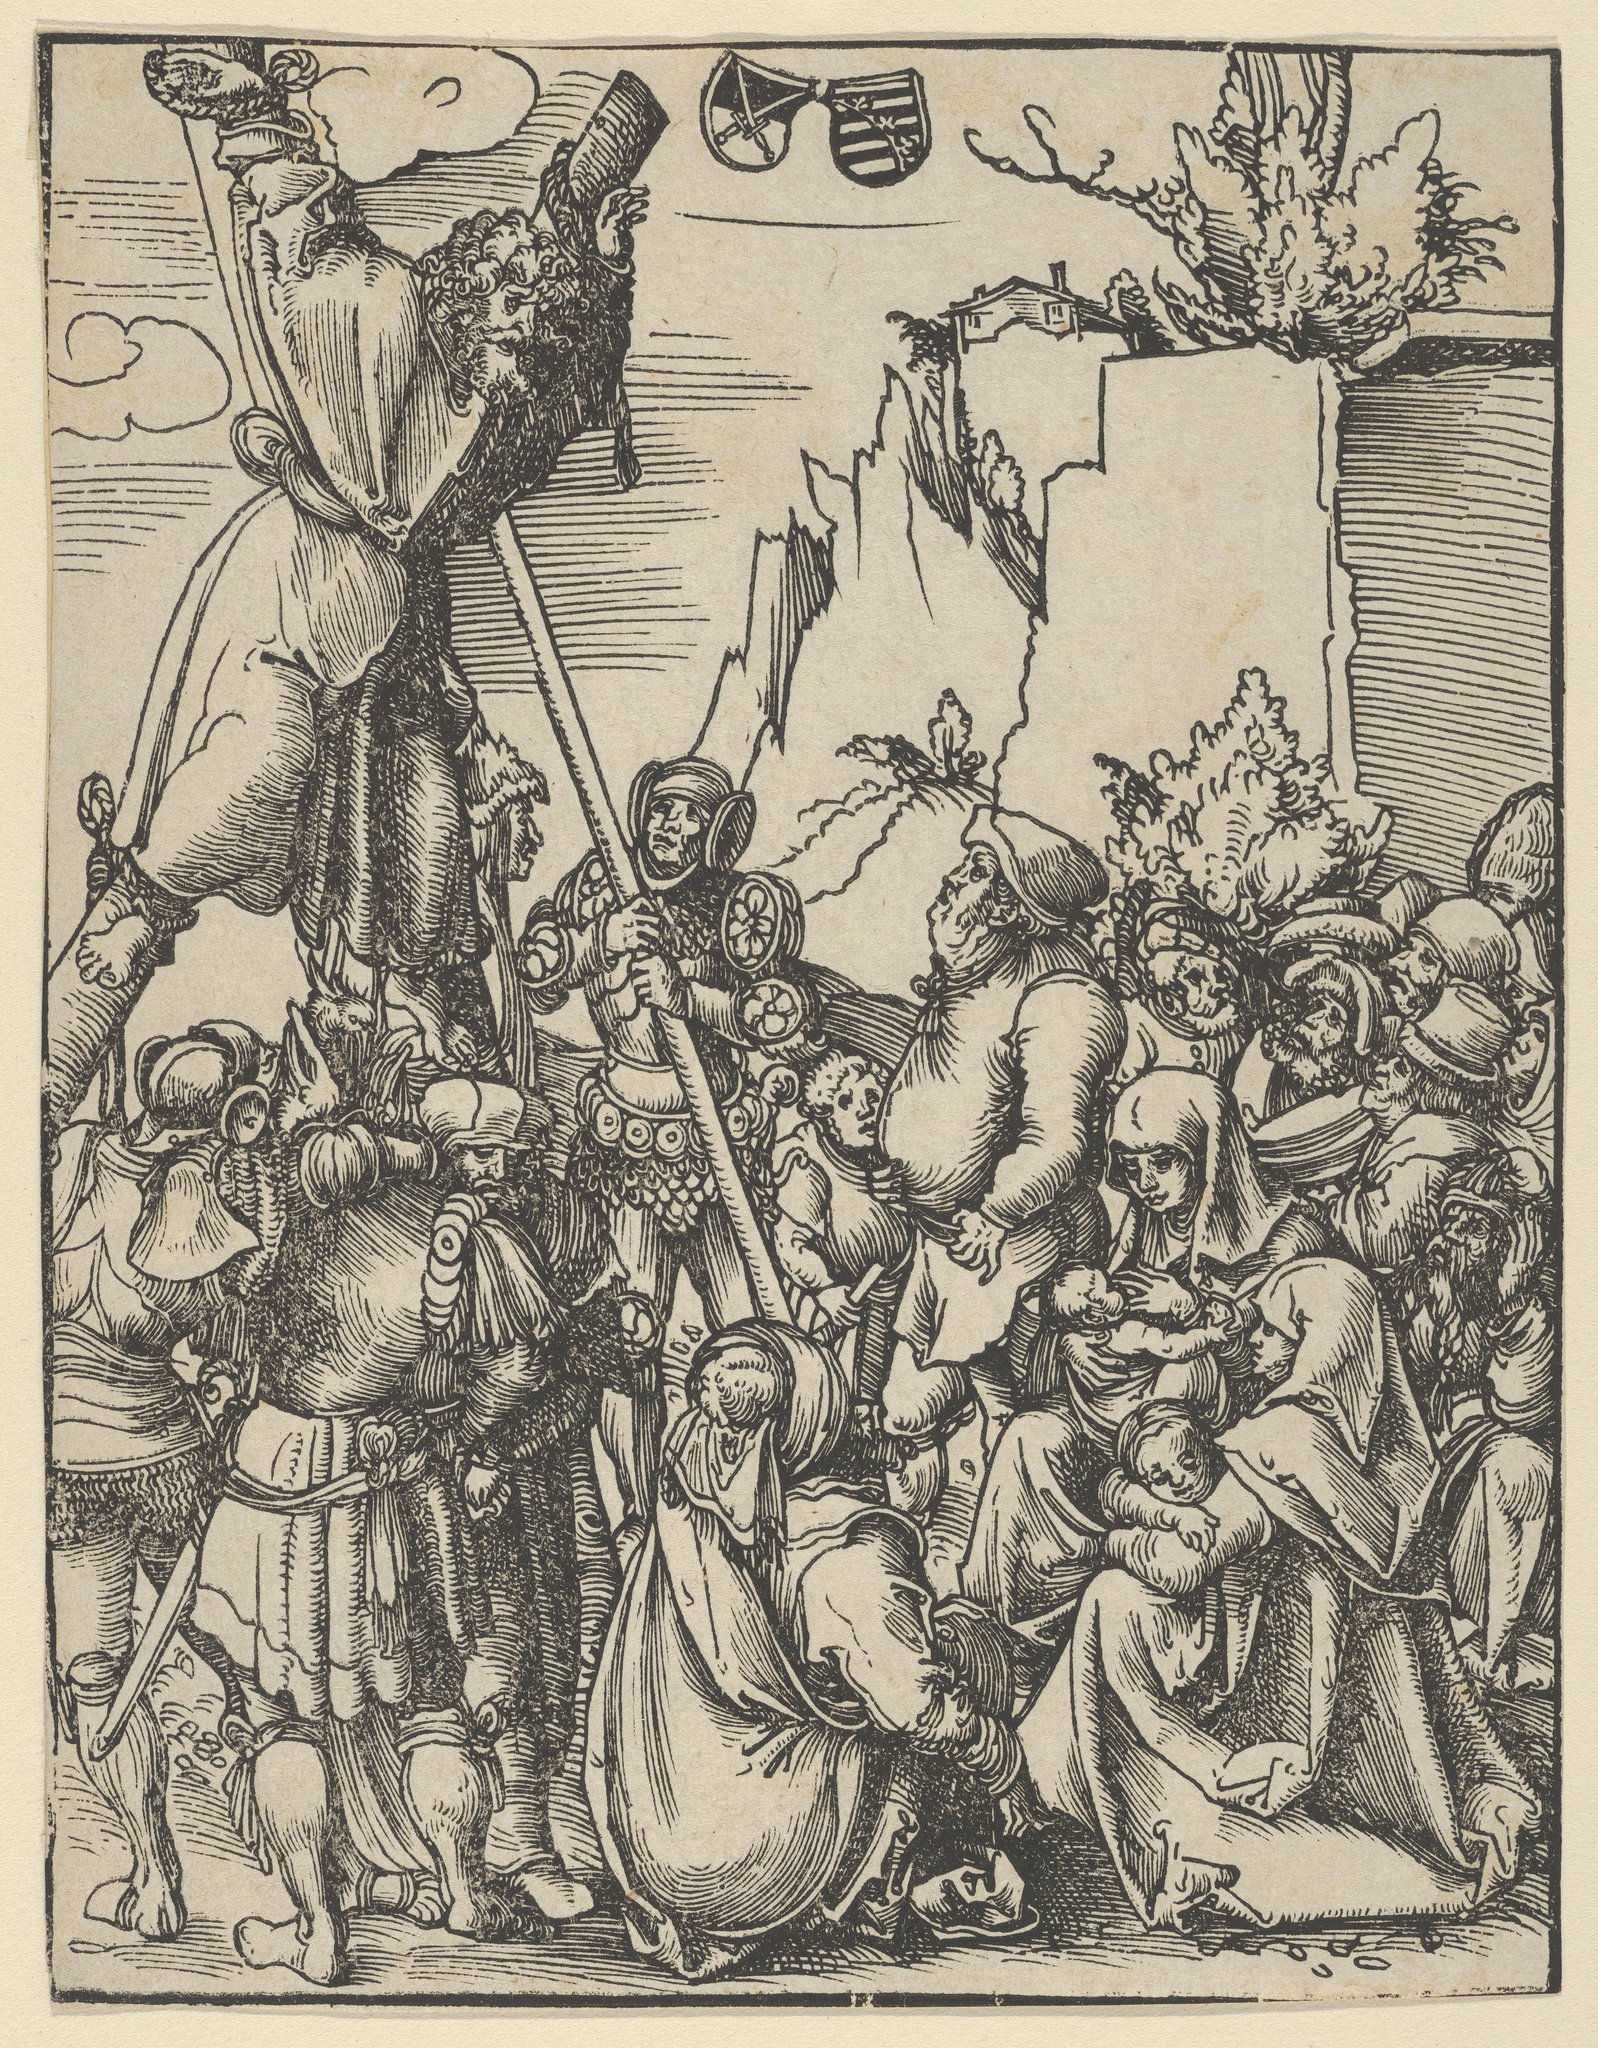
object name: print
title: Andrew from the Martyrdom of the Twelve Apostles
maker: lucas cranach the elder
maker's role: artist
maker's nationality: german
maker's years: 1472-1553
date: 1472-1553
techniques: woodcut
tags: apostles,crucifixion,saints